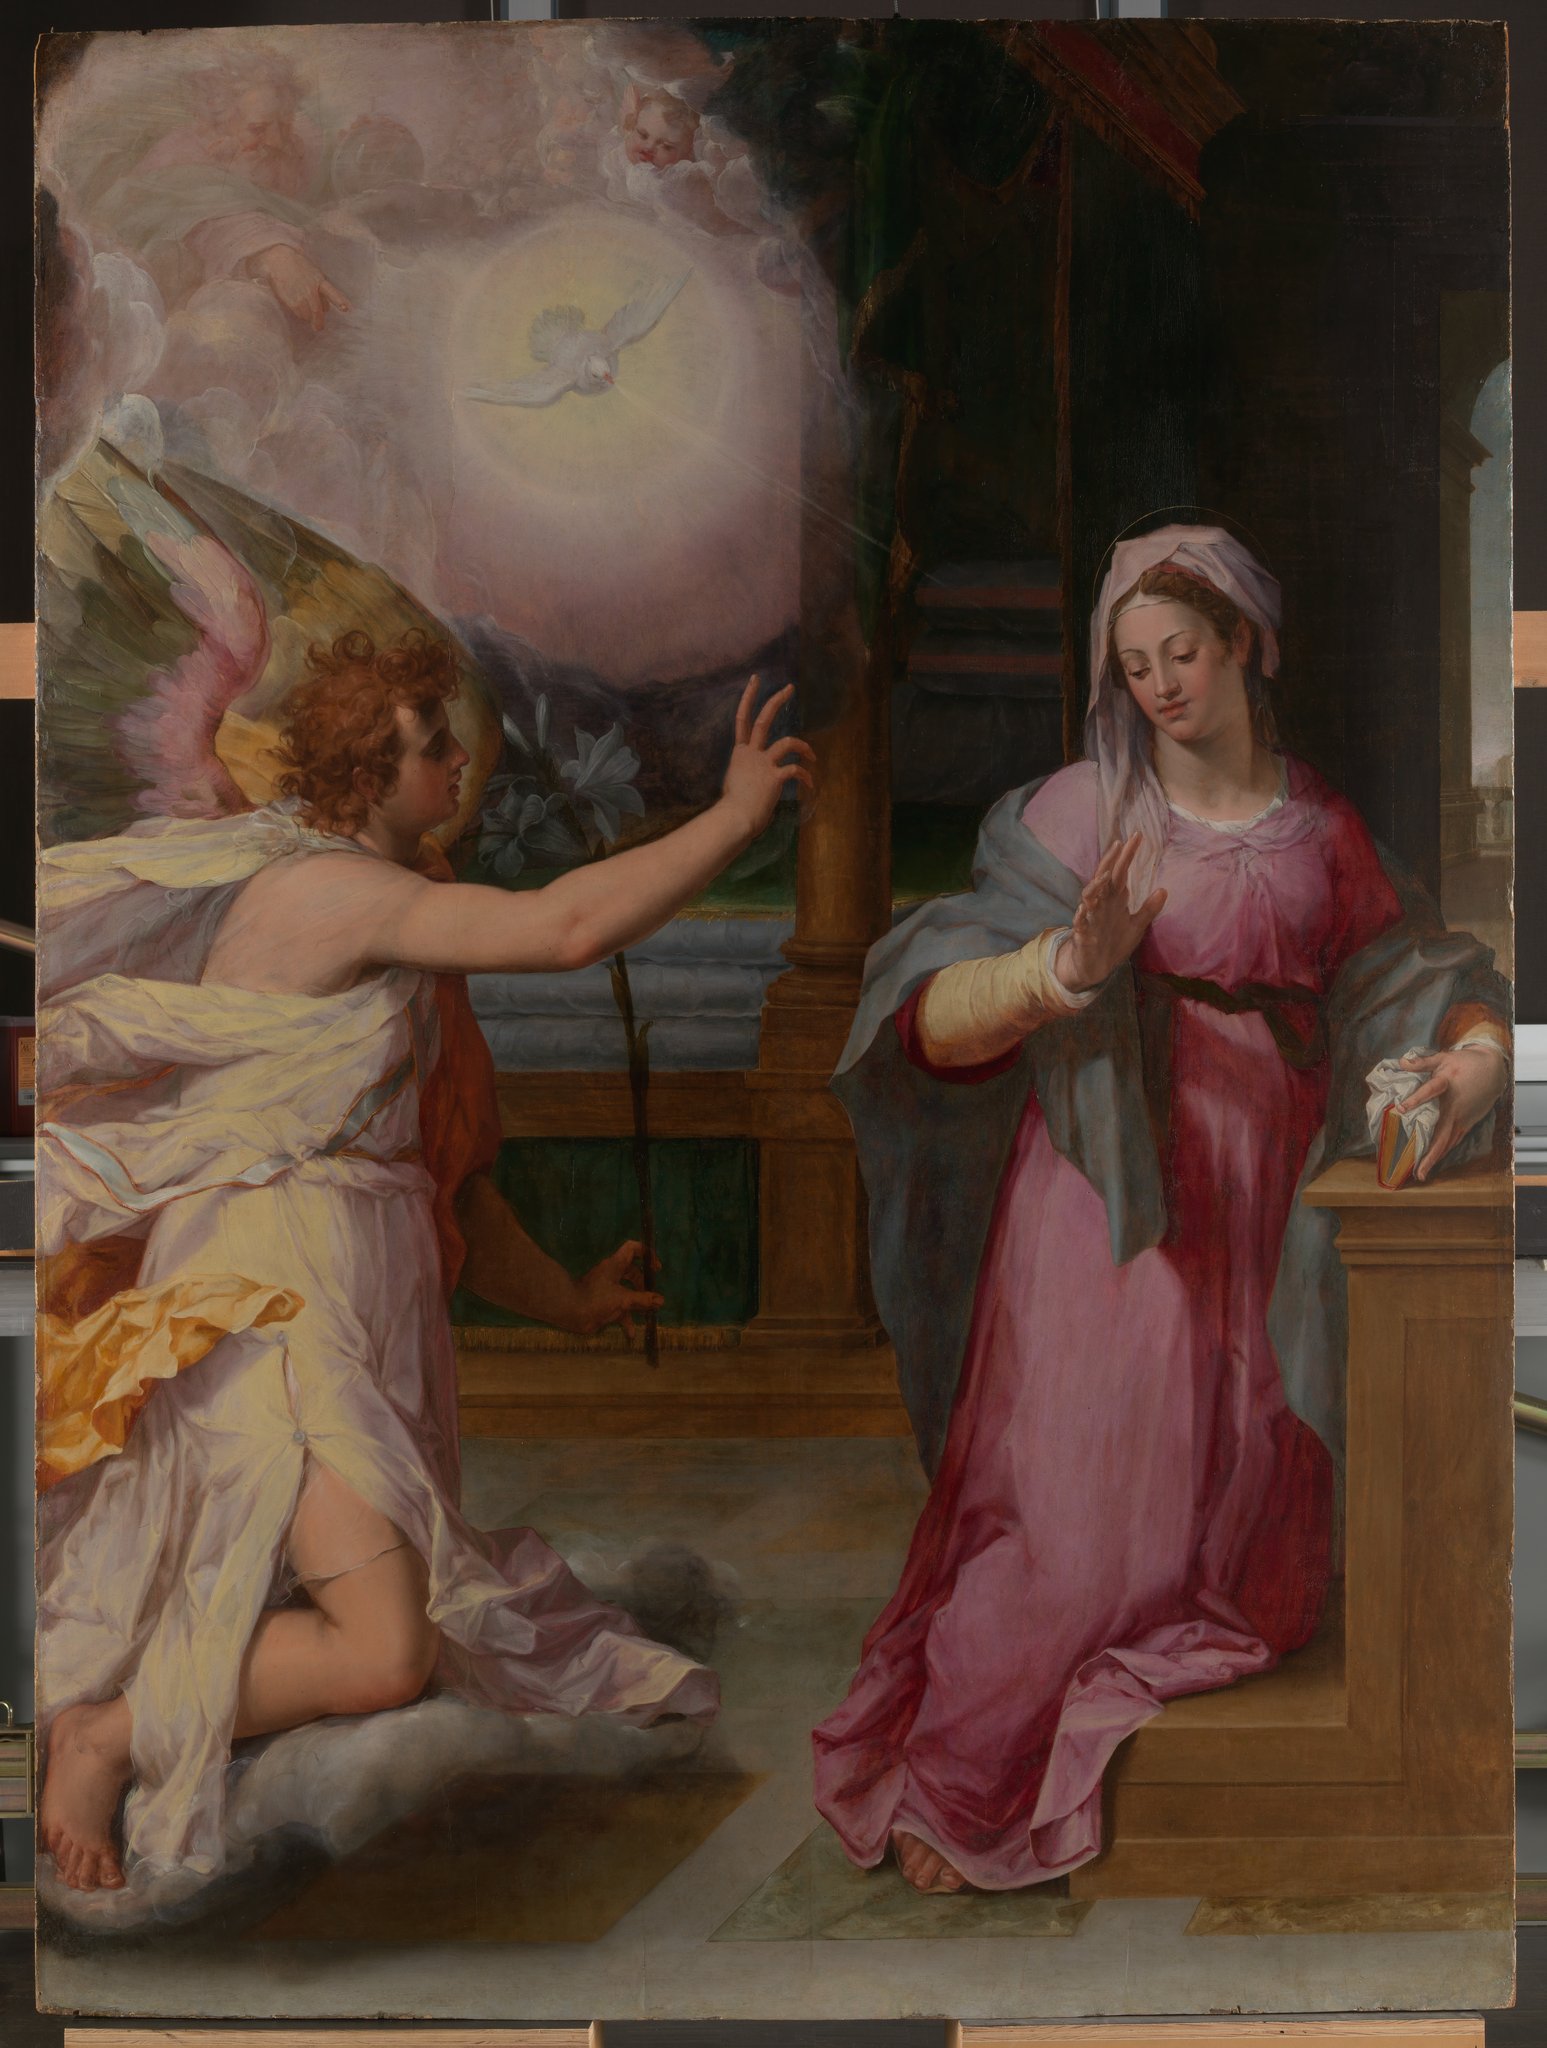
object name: painting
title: The Annunciation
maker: peter candid (pieter de witte, pietro candido)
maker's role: artist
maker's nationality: netherlandish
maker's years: 1548-1628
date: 1585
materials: oil, wood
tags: doves,virgin mary,archangel gabriel,annunciation